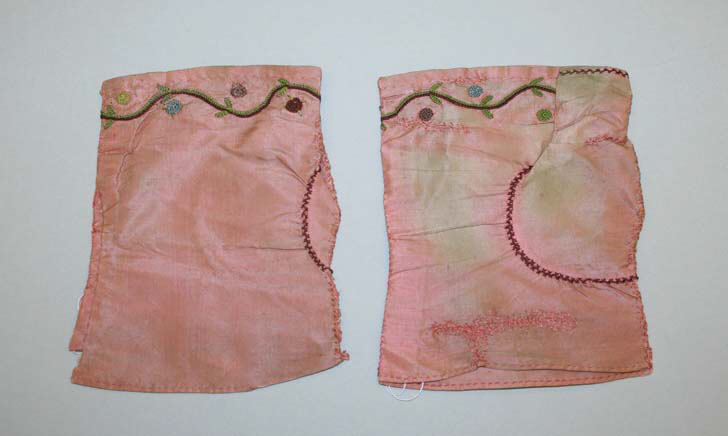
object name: mitt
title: Mitts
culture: european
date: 1701-1800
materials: silk